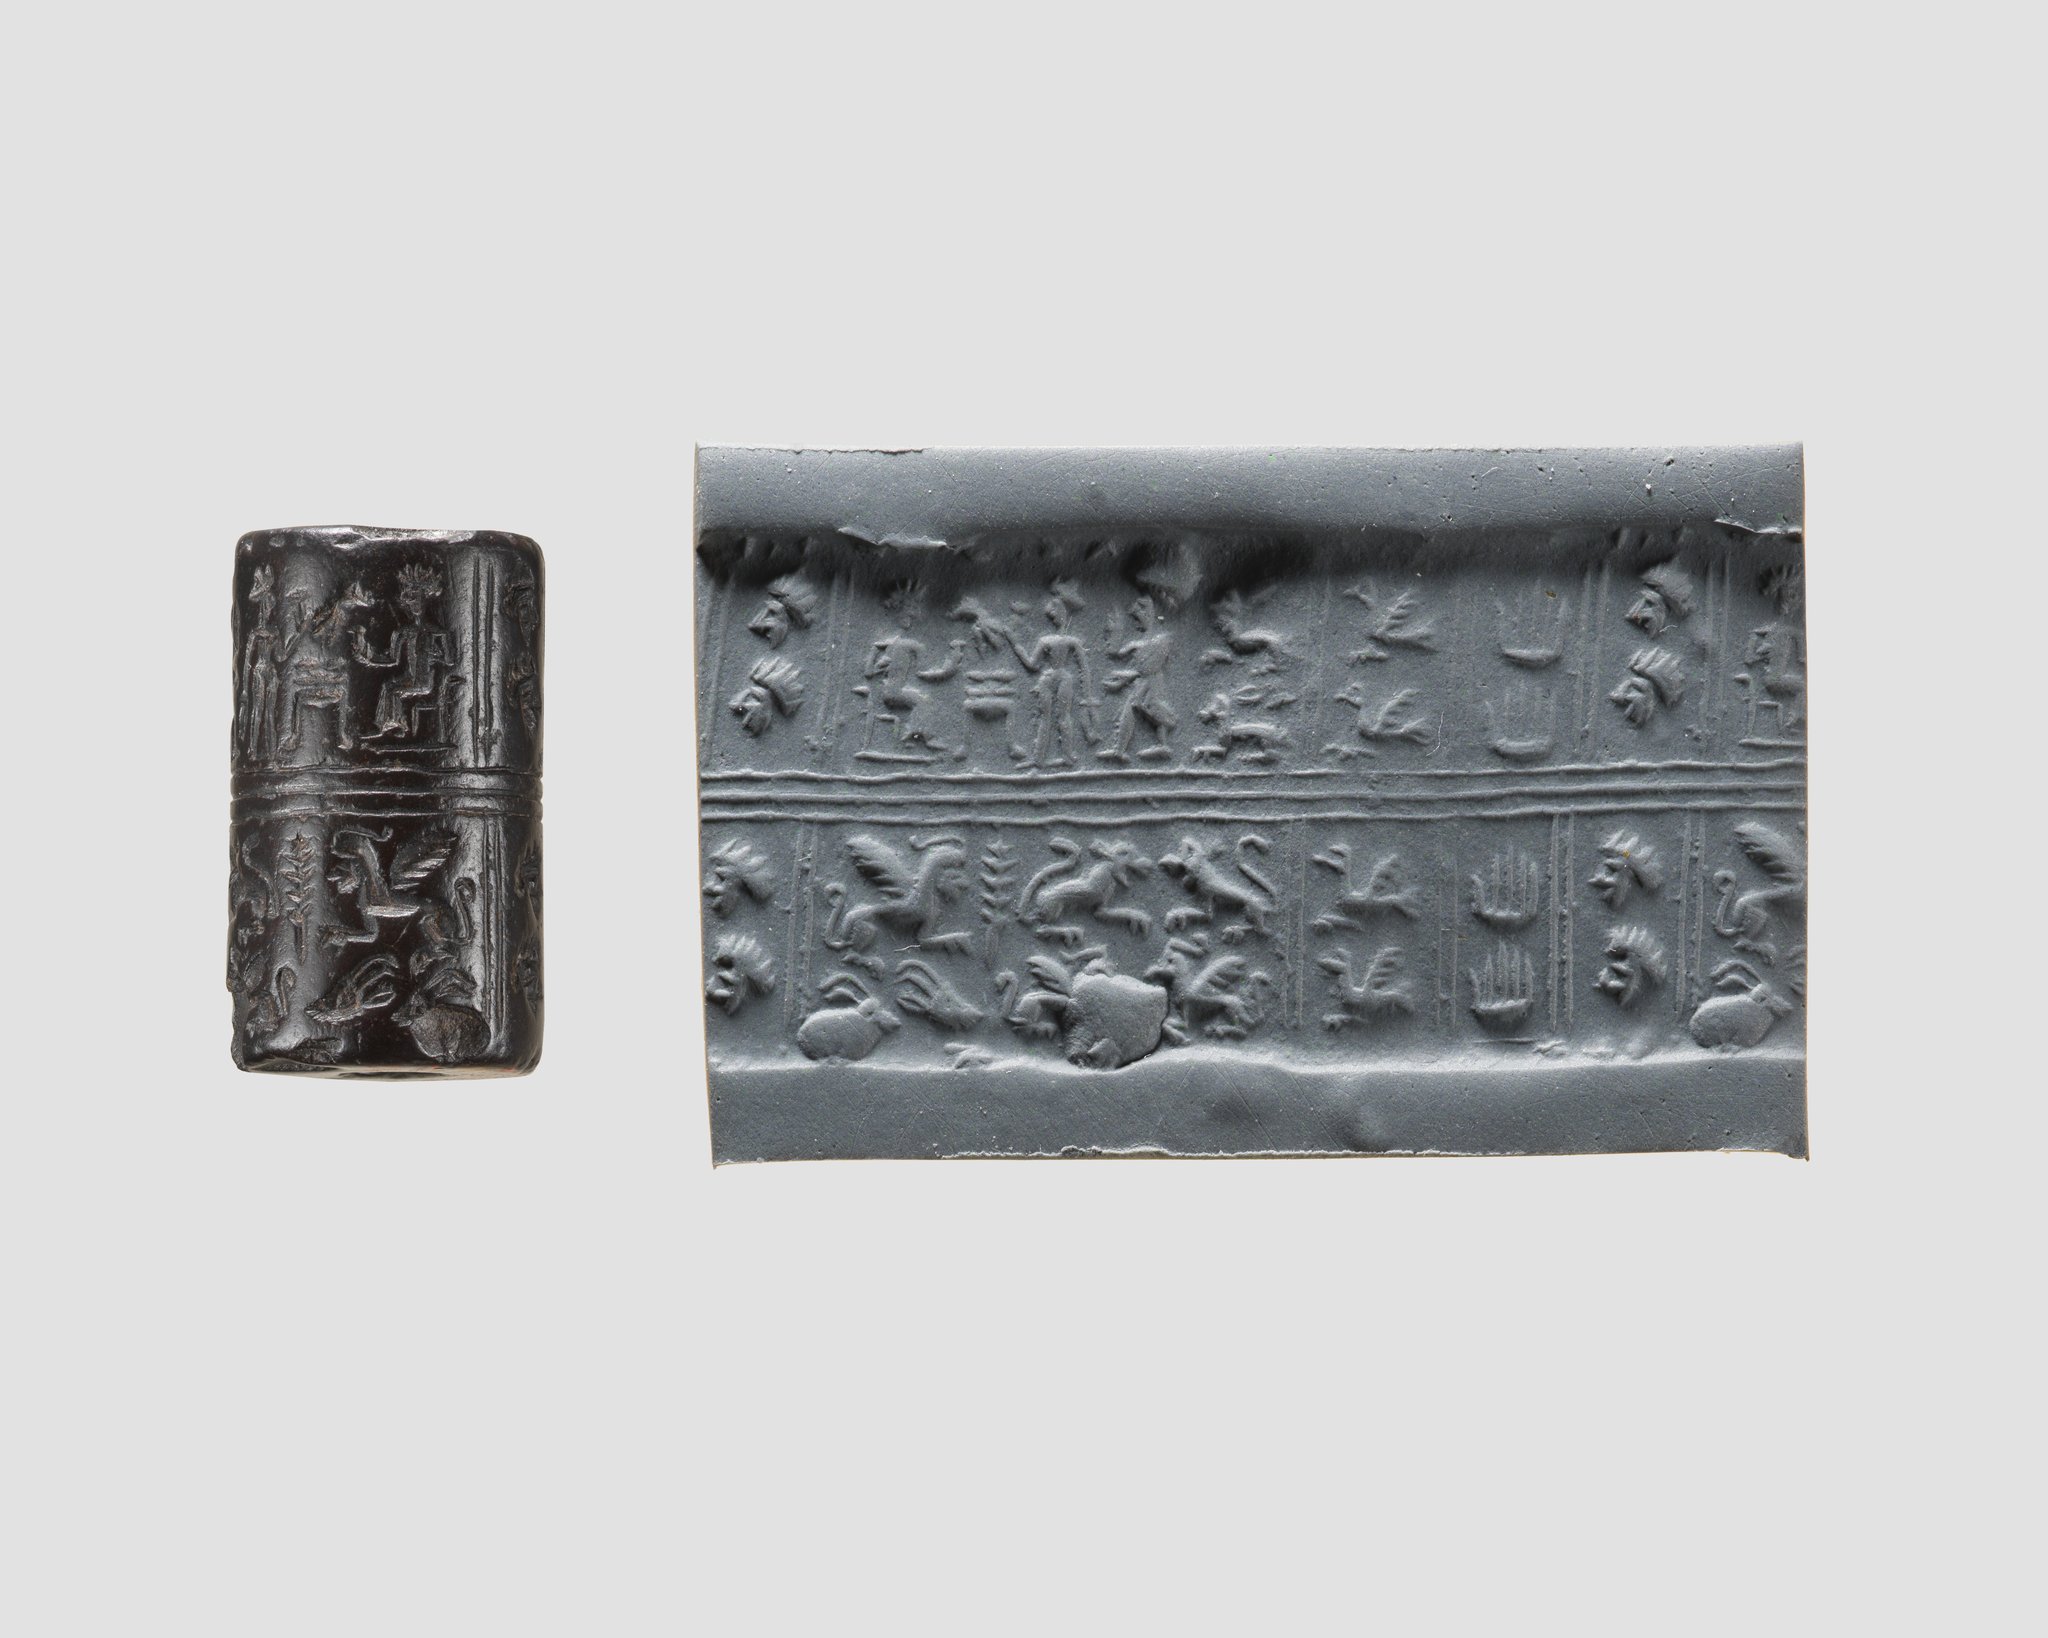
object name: cylinder seal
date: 1820-1730 BCE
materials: mineral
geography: syria